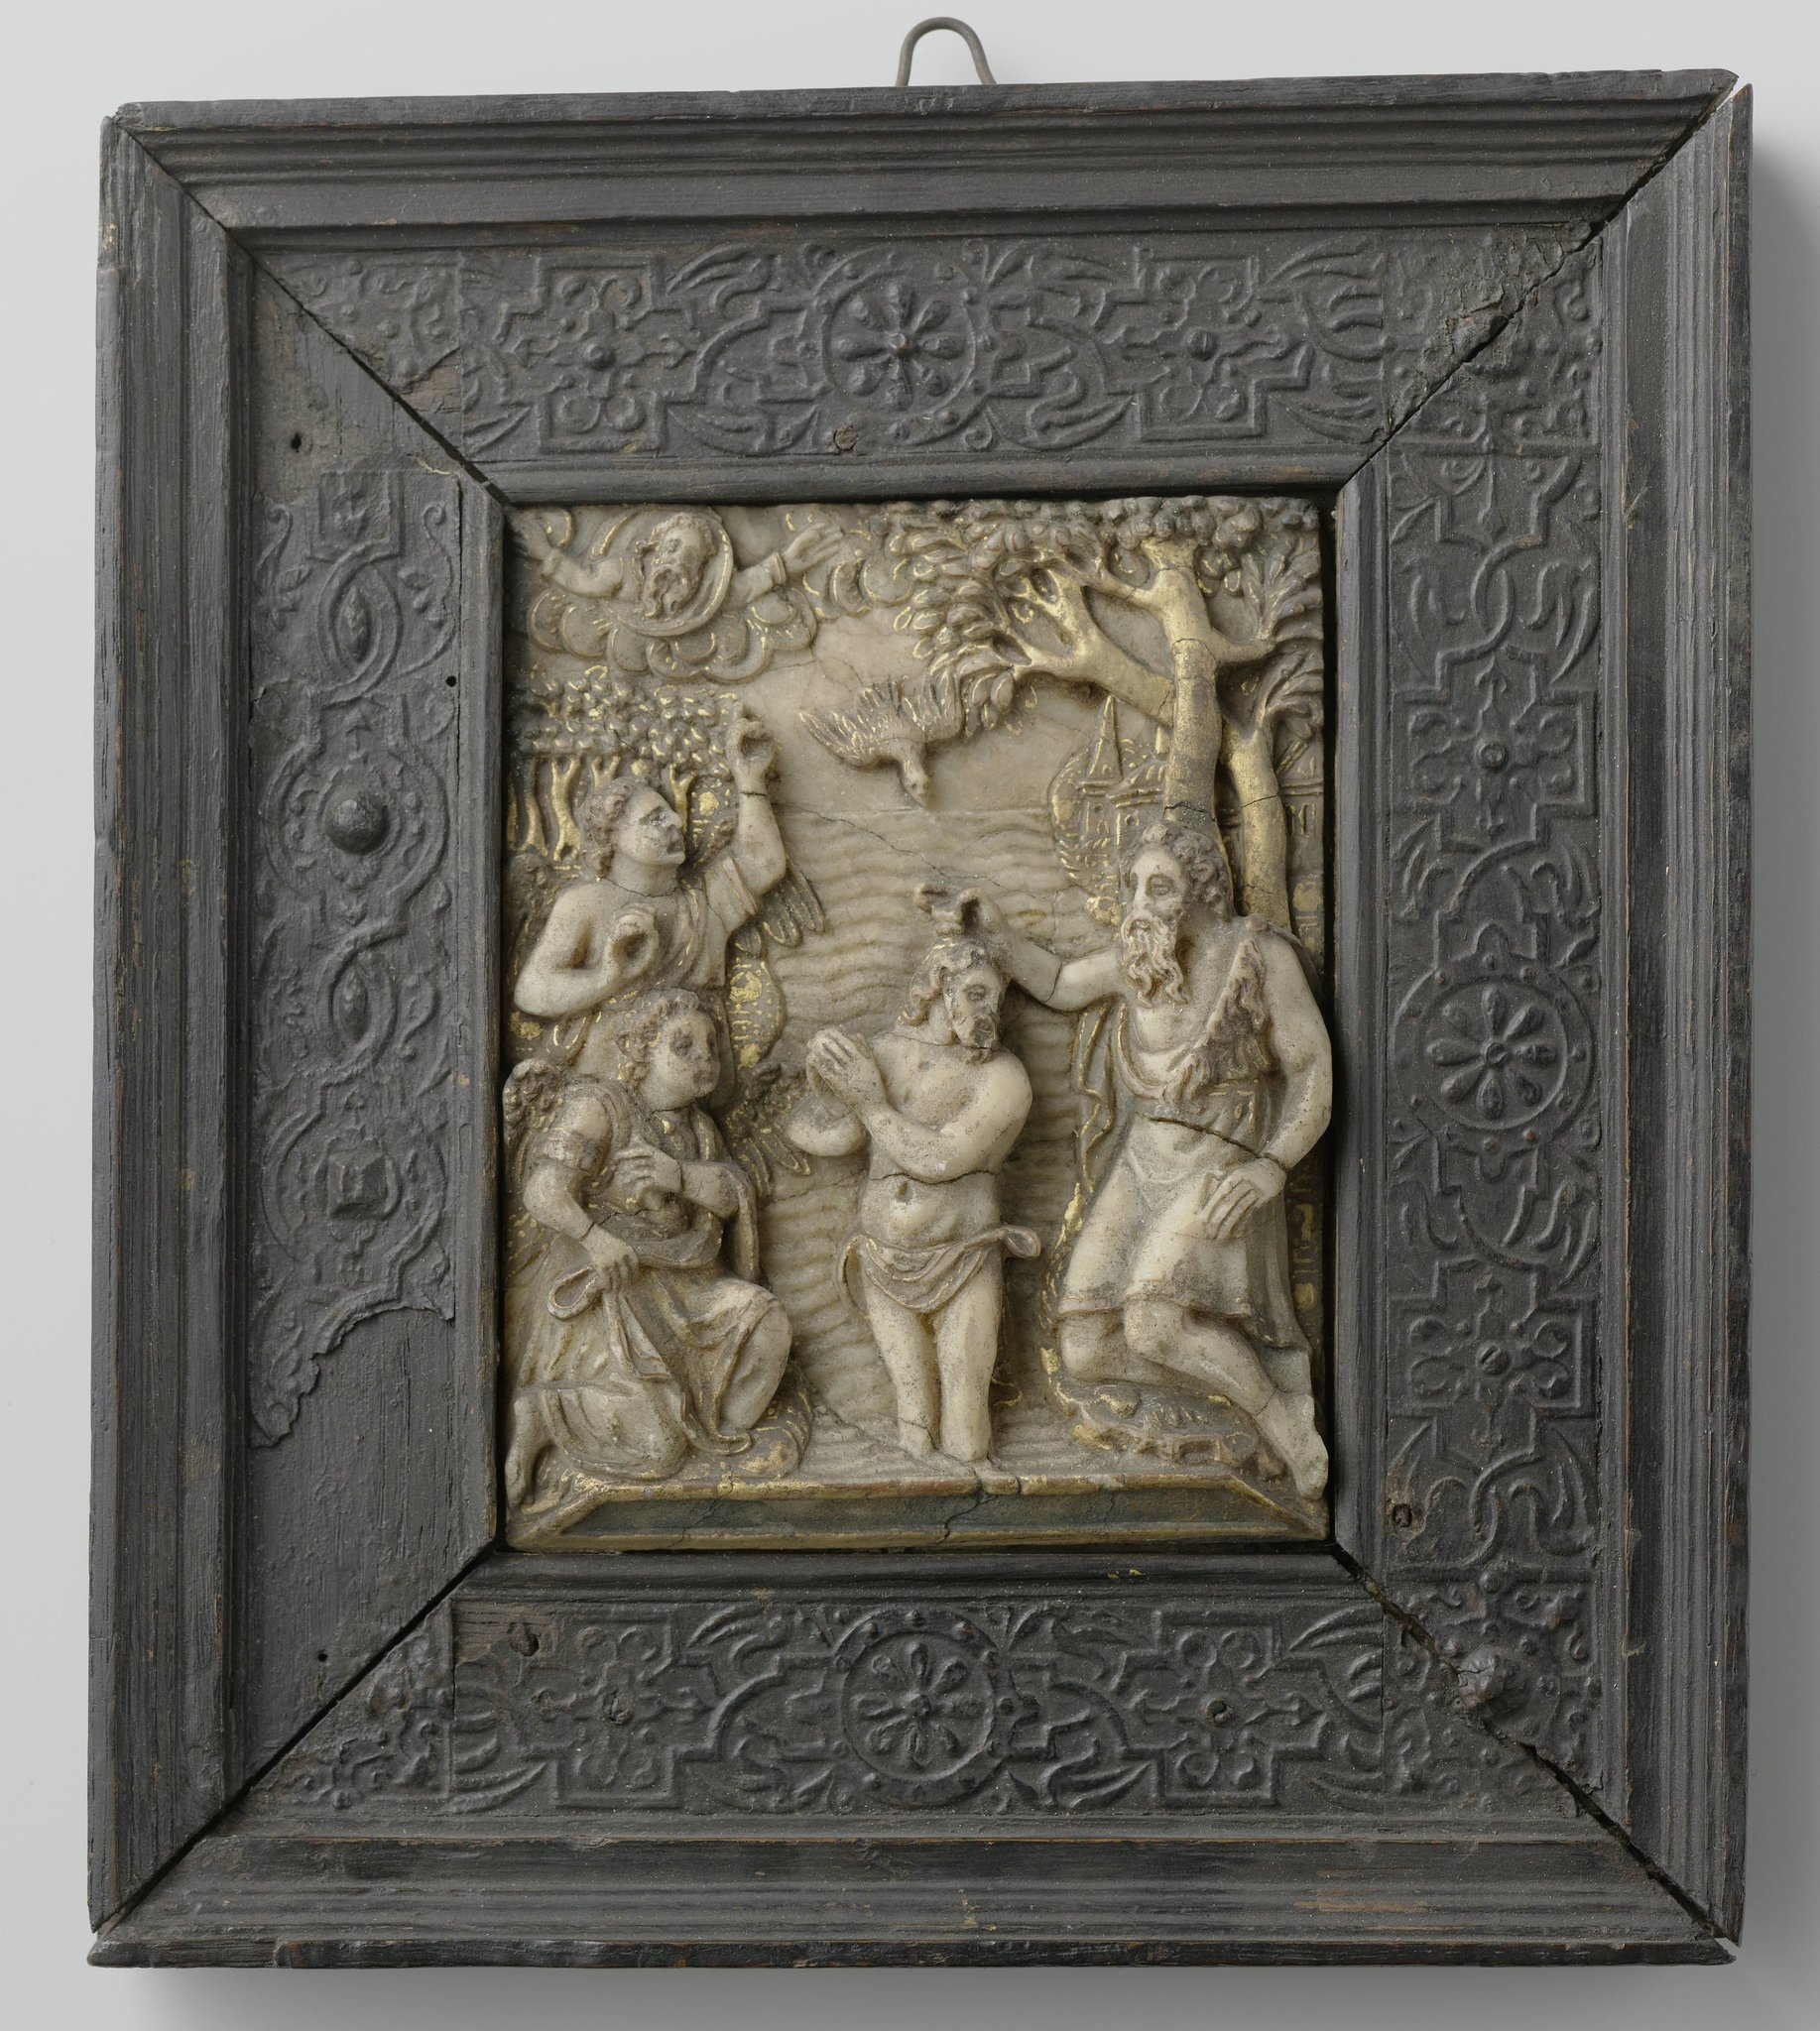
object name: sculpture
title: Baptism of Christ in the River Jordan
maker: tobias van tissenaken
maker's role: sculptor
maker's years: 1560-1624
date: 1600-1624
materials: alabaster, wood, plaster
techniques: gilding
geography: mechelen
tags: baptism of christ in the river jordan: john the baptist pouring out water on christ's head: the holy ghost descends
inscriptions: maker's mark, right on the angled cartouche beneath the scene, in gold paint: a house mark (4 with interlocking H), between the initials TvT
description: In het midden tegen de achtergrond van de Jordaan staat Christus met gevouwen handen tot de knieën in het water. Rechts knielt Johannes op de oever en houdt een schelp met water boven Christus' hoofd ; op de linker oever een knielende en een staande engel, de laatste wijst naar boven. Op de achtergrond links een bos en rechts enkele bomen voor gebouwen, in de lucht de Heilige Geest in de gedaante van een duif en God de Vader verschijnend uit de wolken. De onderkant van het reliëf is afgeschuind tot een langwerpige paneeltje.